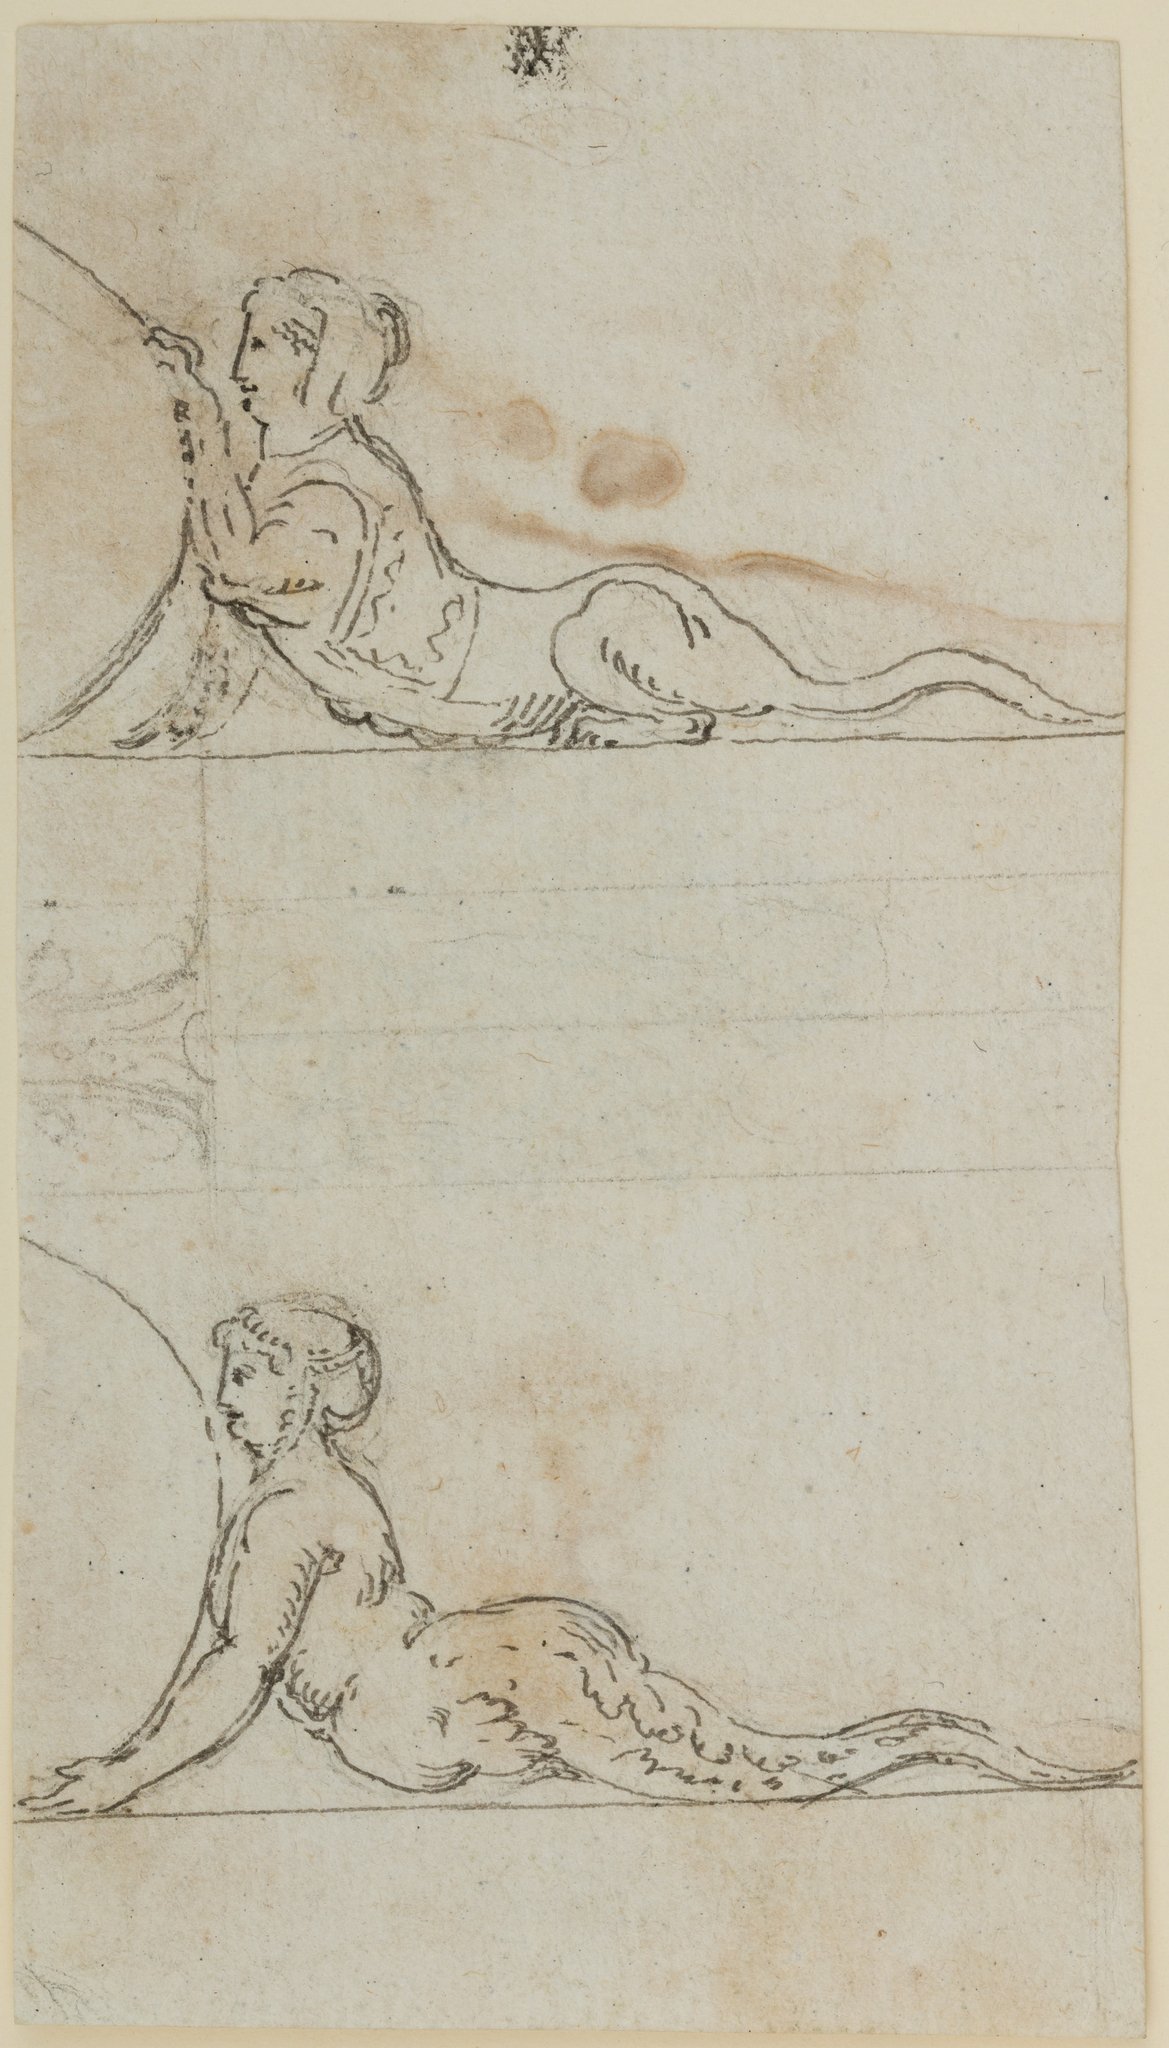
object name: drawing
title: Designs for the Decoration of Firearms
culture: french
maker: nicolas noël boutet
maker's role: designer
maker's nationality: french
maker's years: 1761-1833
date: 1797-1805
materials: ink, paper, pencil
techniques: wash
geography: france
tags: ornament,mythical creatures